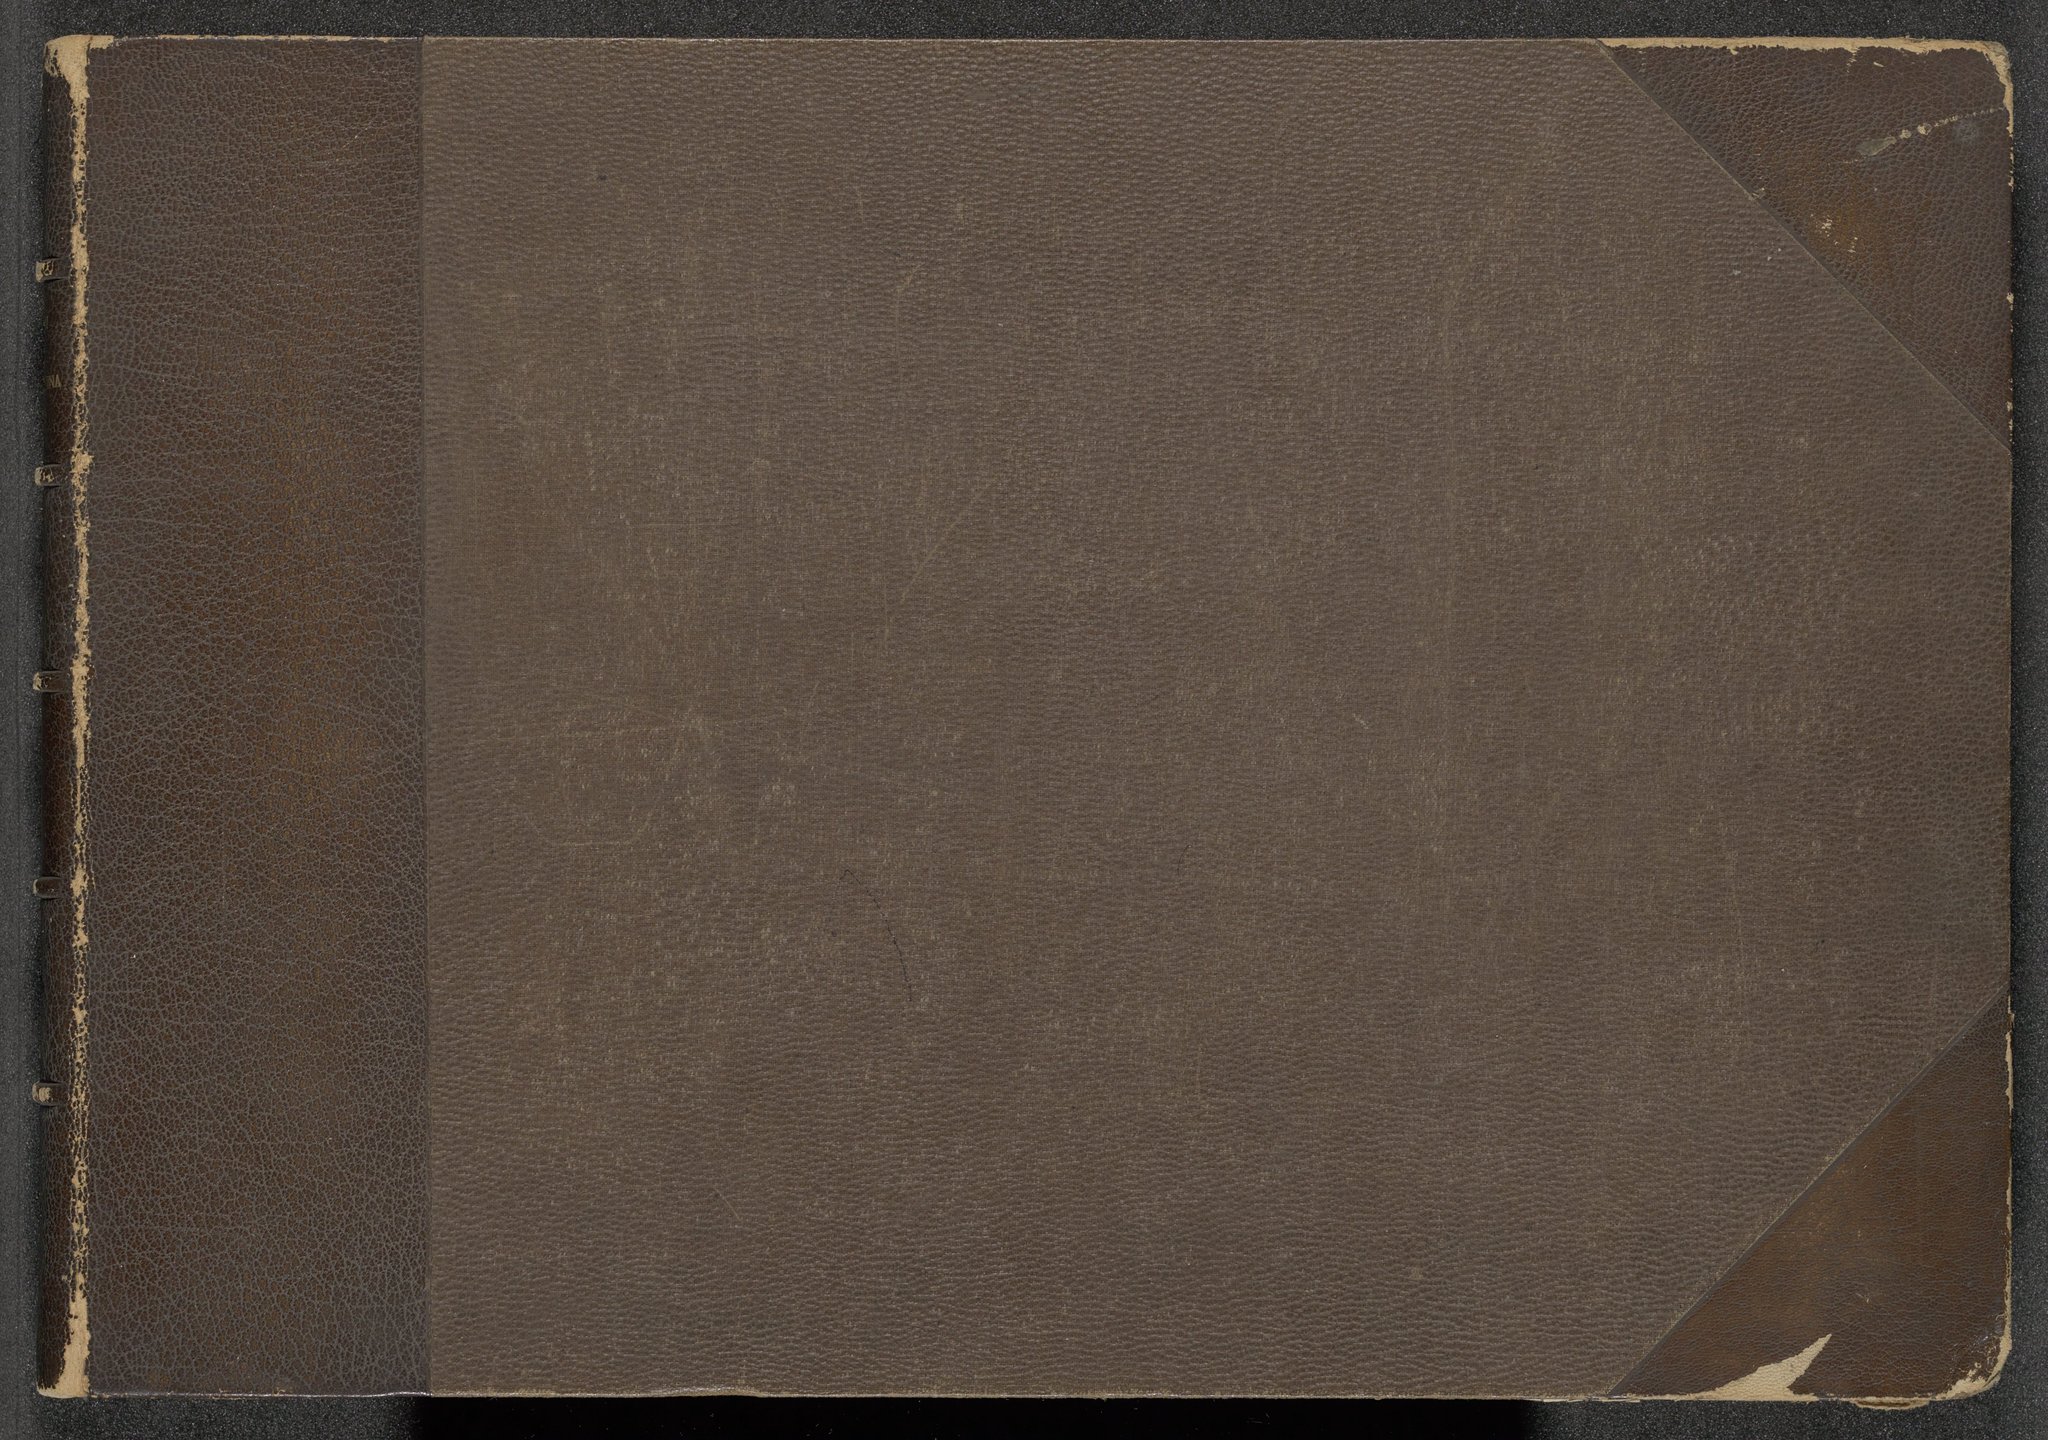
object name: book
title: Album of the Japan-China war 1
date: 1896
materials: cardboard, linen, paper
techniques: photograph, printing, marbled paper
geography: tokyo